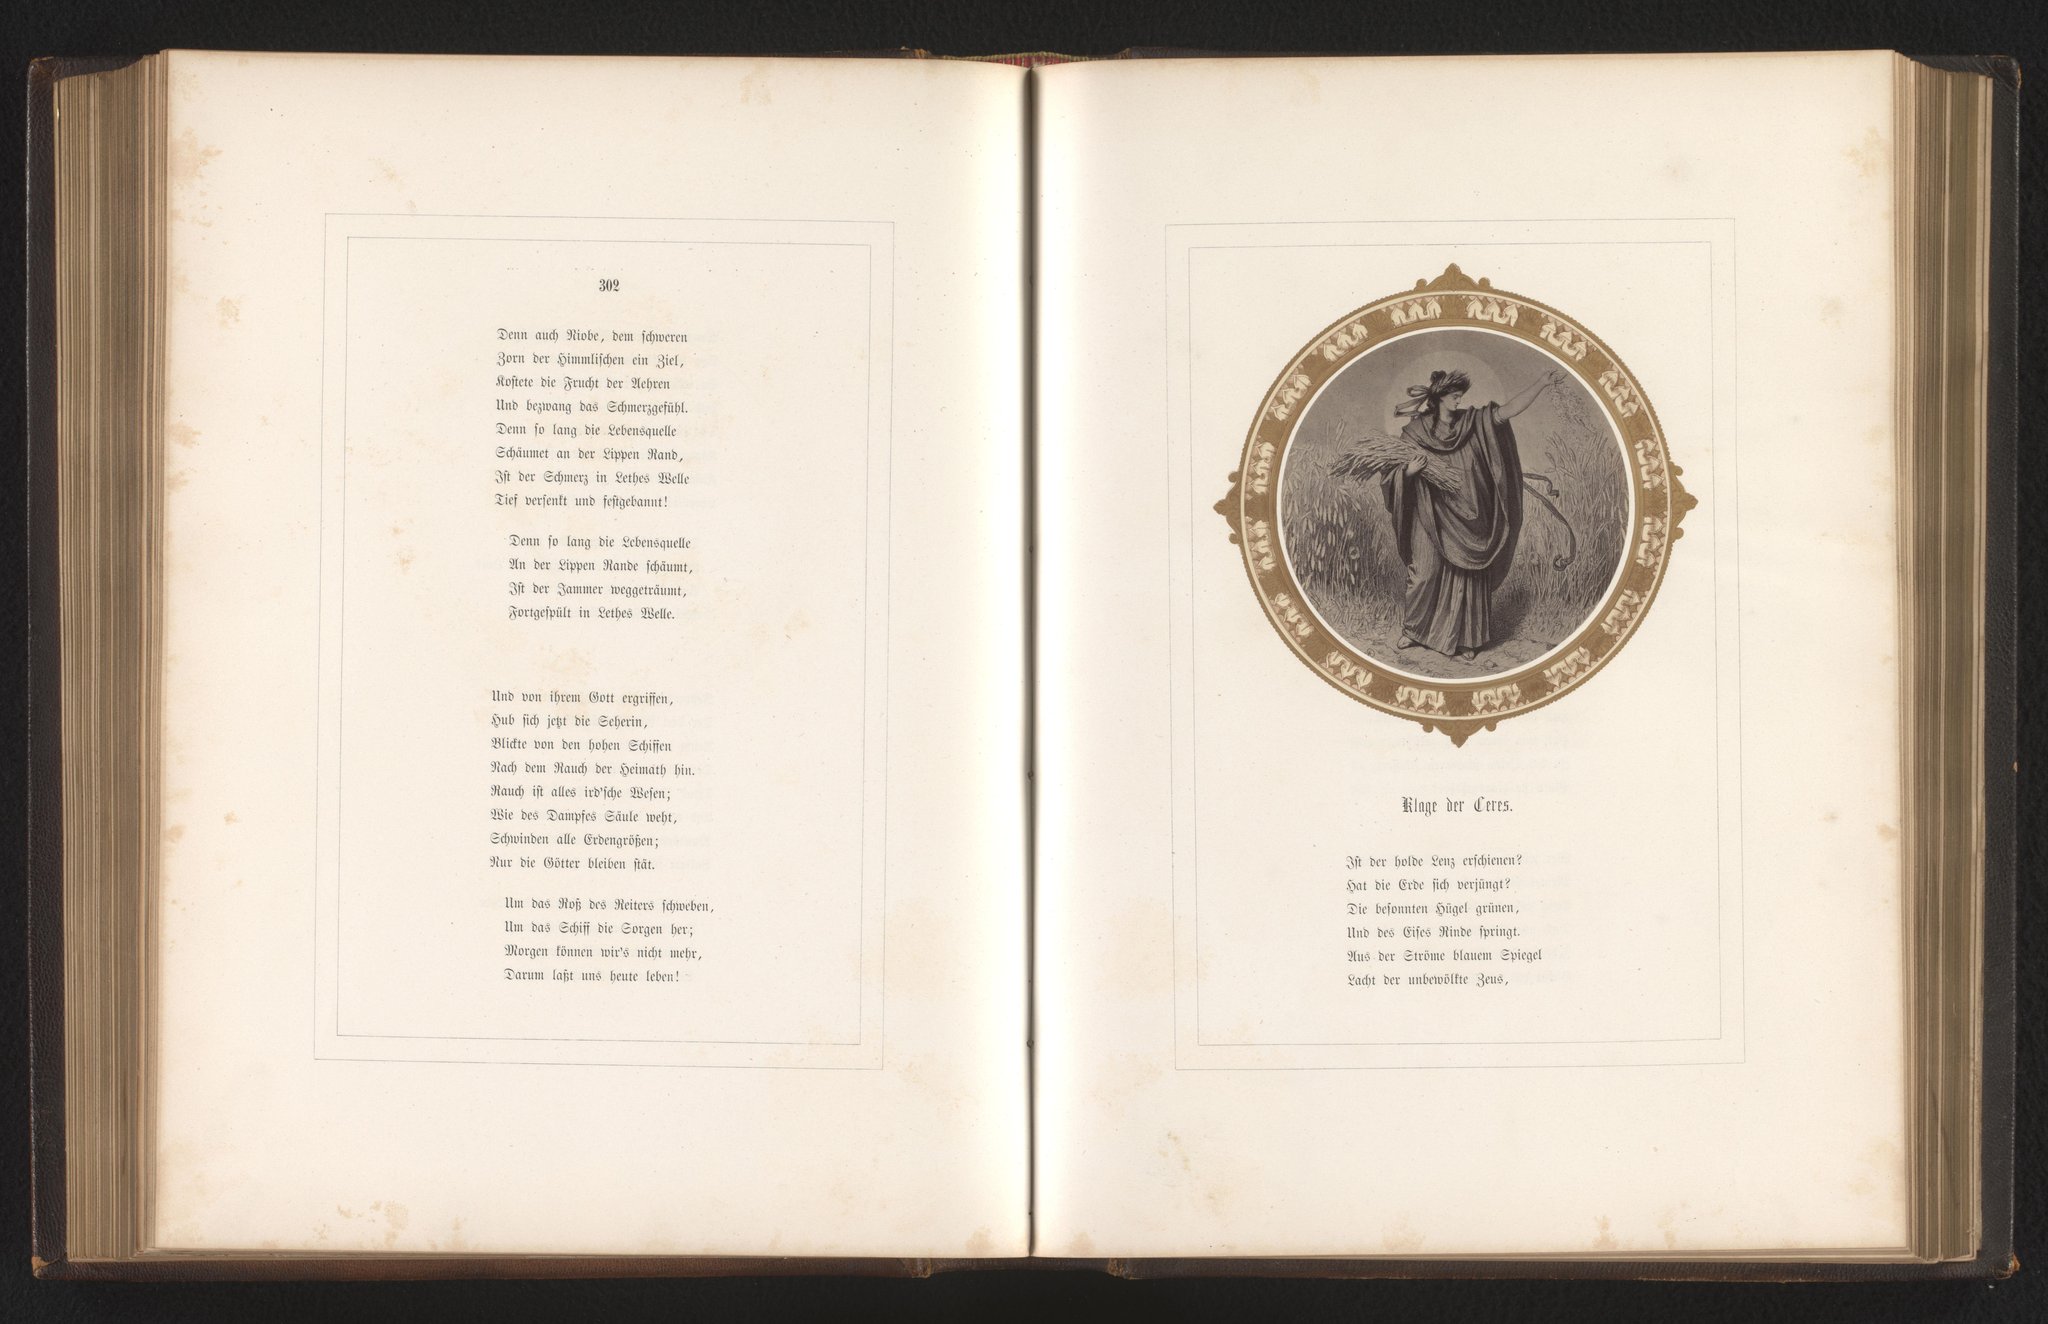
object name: reproduction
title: Fotoreproductie van een tekening van Ceres door Karl Piloty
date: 1855-1862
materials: paper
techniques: albumen print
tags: (story of) ceres (demeter)